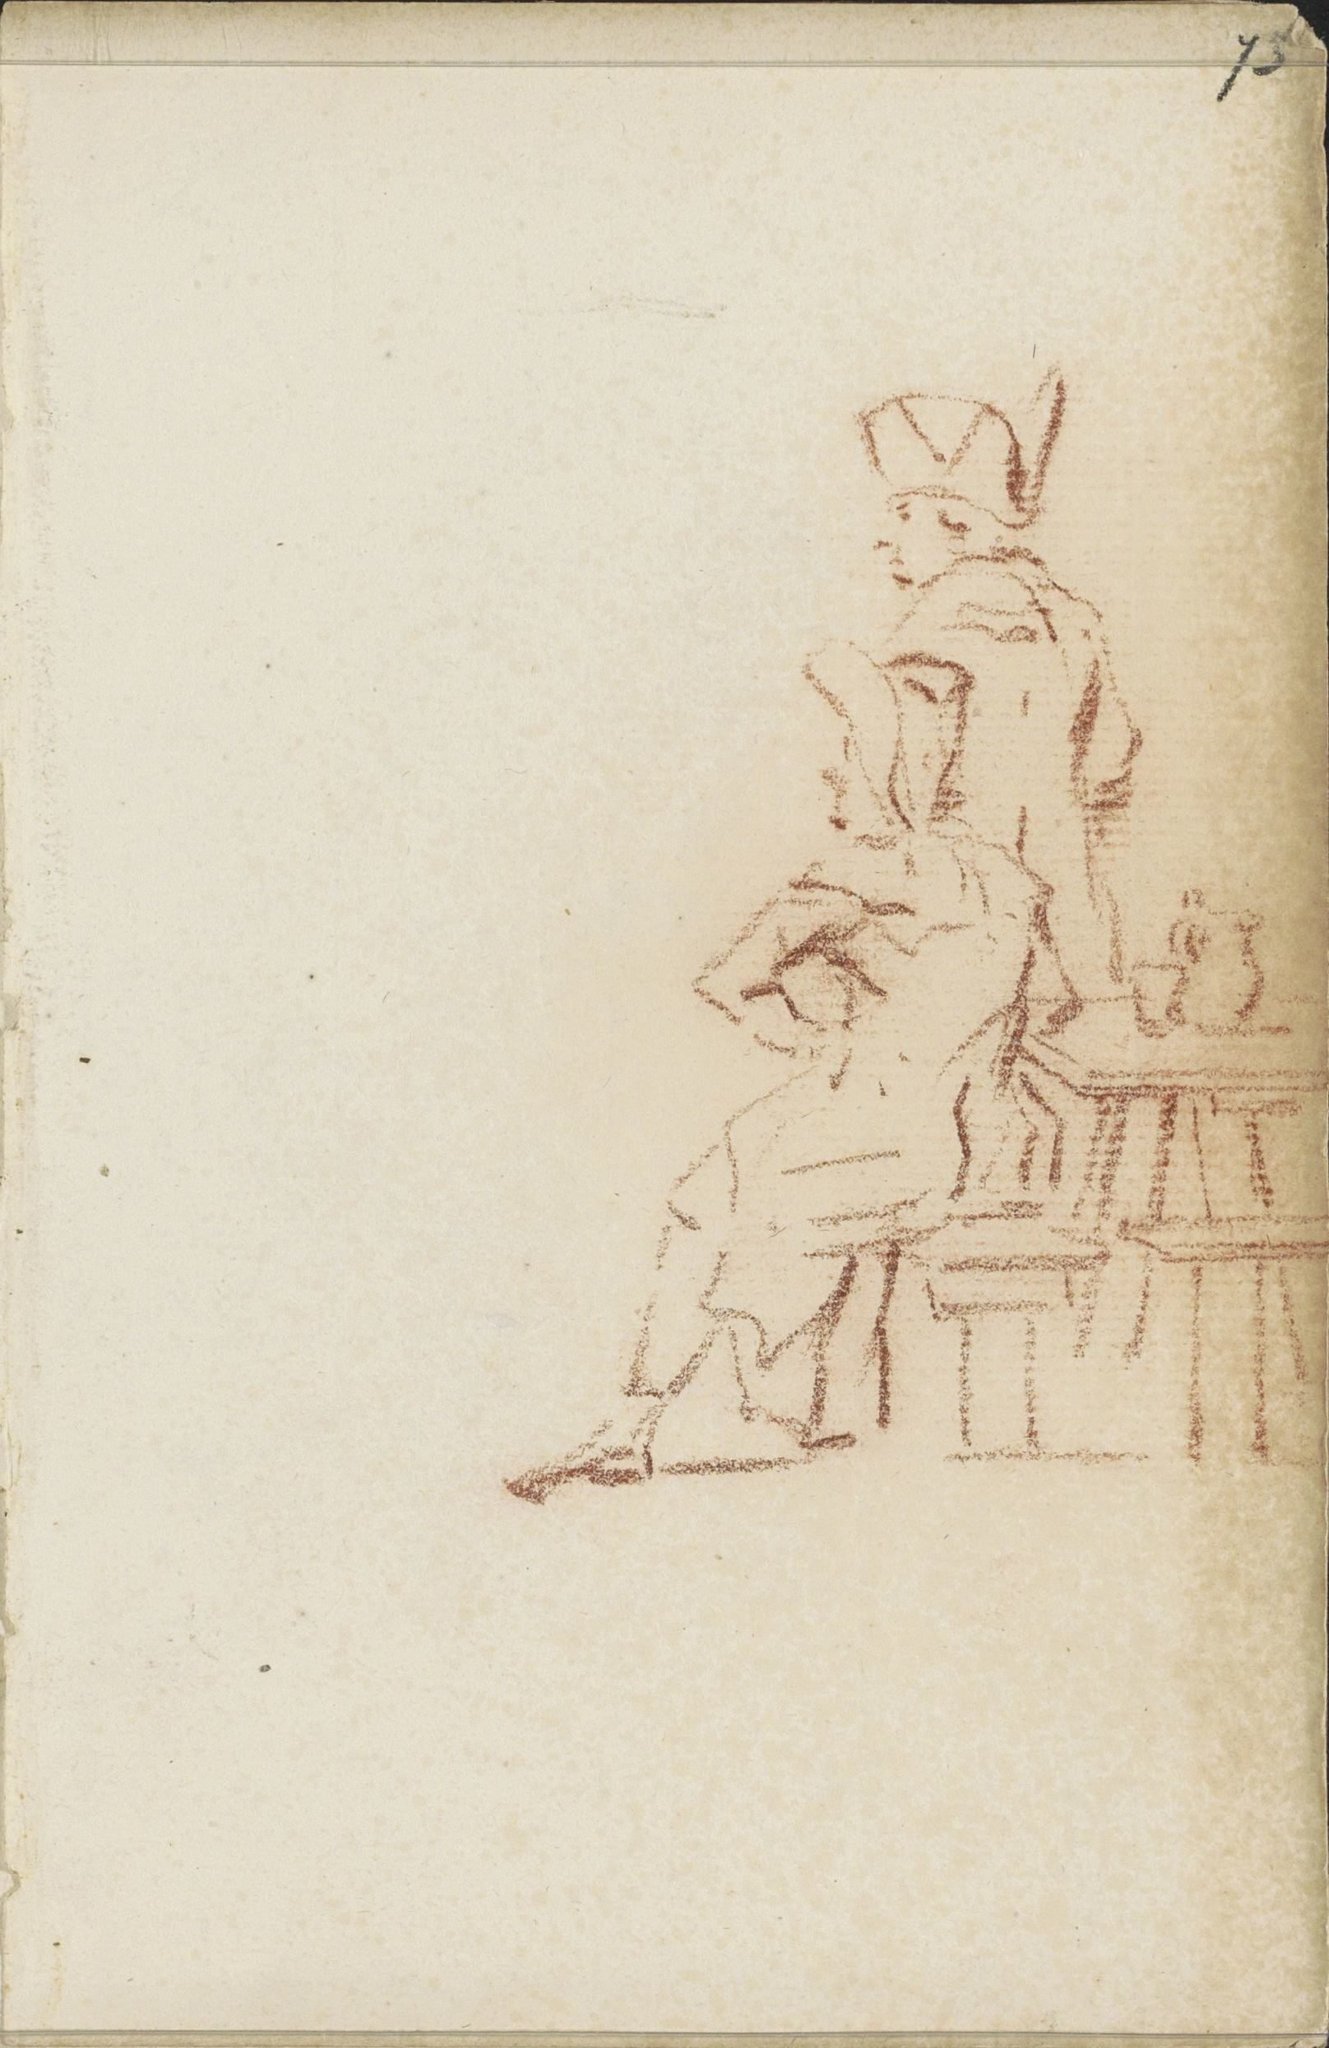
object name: sketchbook leaf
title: Twee gekostumeerde figuren bij een tafel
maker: jacob perkois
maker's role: draughtsman, print maker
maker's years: 1756-1804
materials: chalk, paper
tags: table, clothes, costume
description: Op de tafel staan een kan en glas. Bladzijde 73 uit een schetsboek met 78 bladzijden.